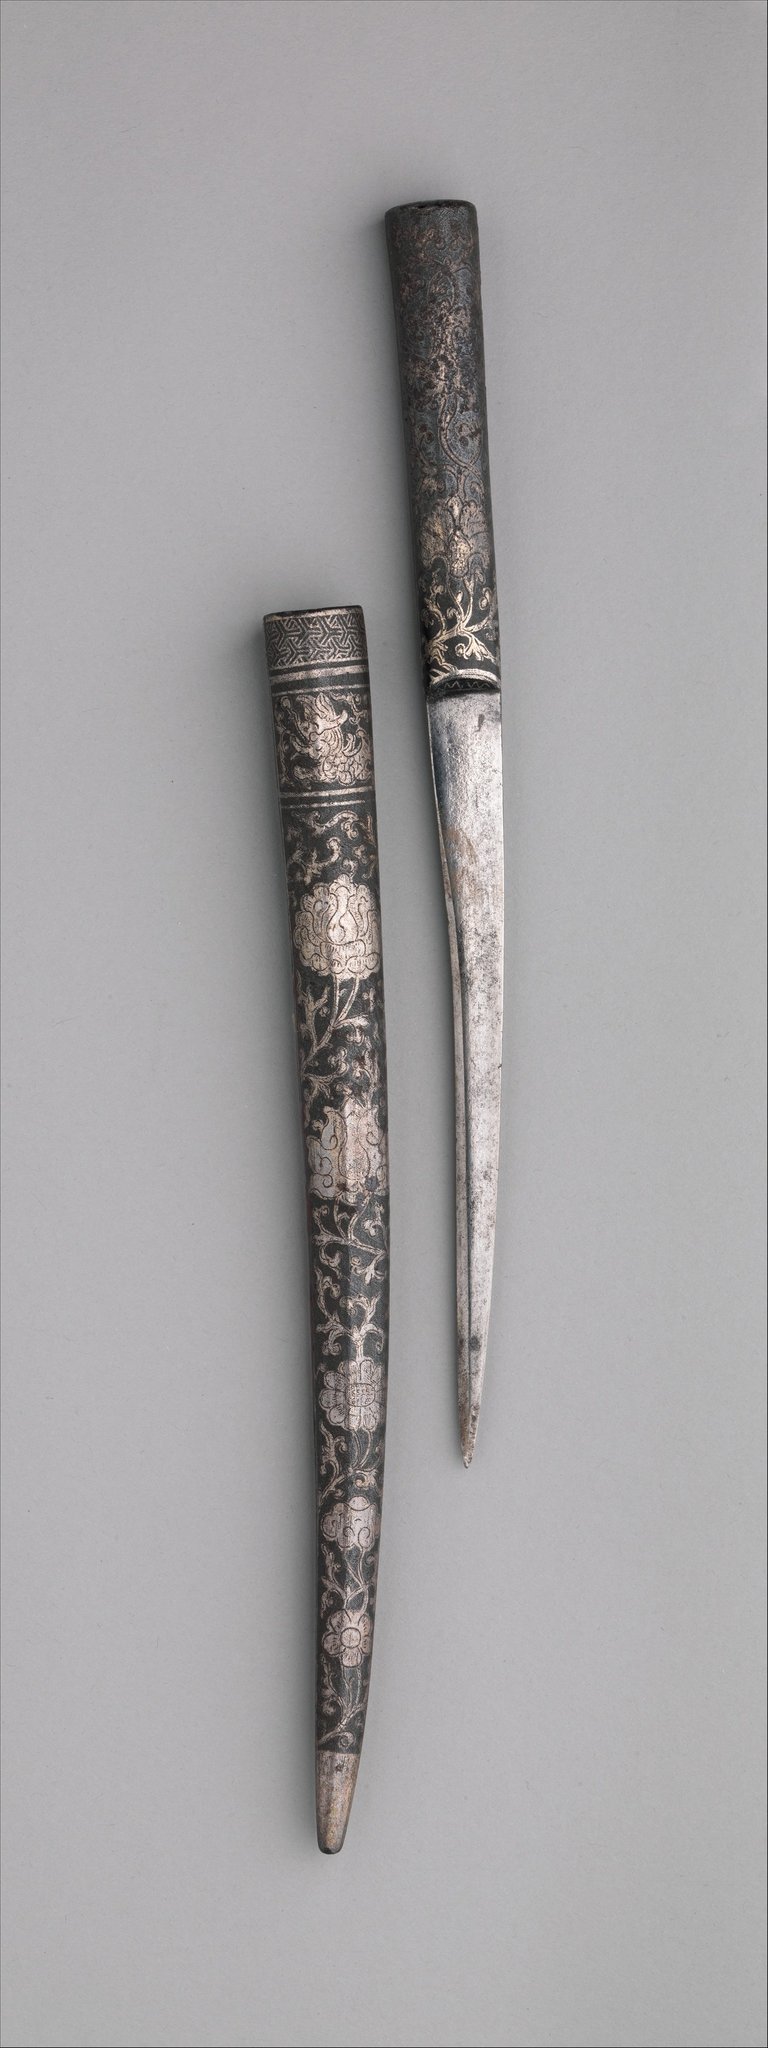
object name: dagger with sheath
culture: central or west asian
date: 1301-1500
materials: iron, silver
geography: asia